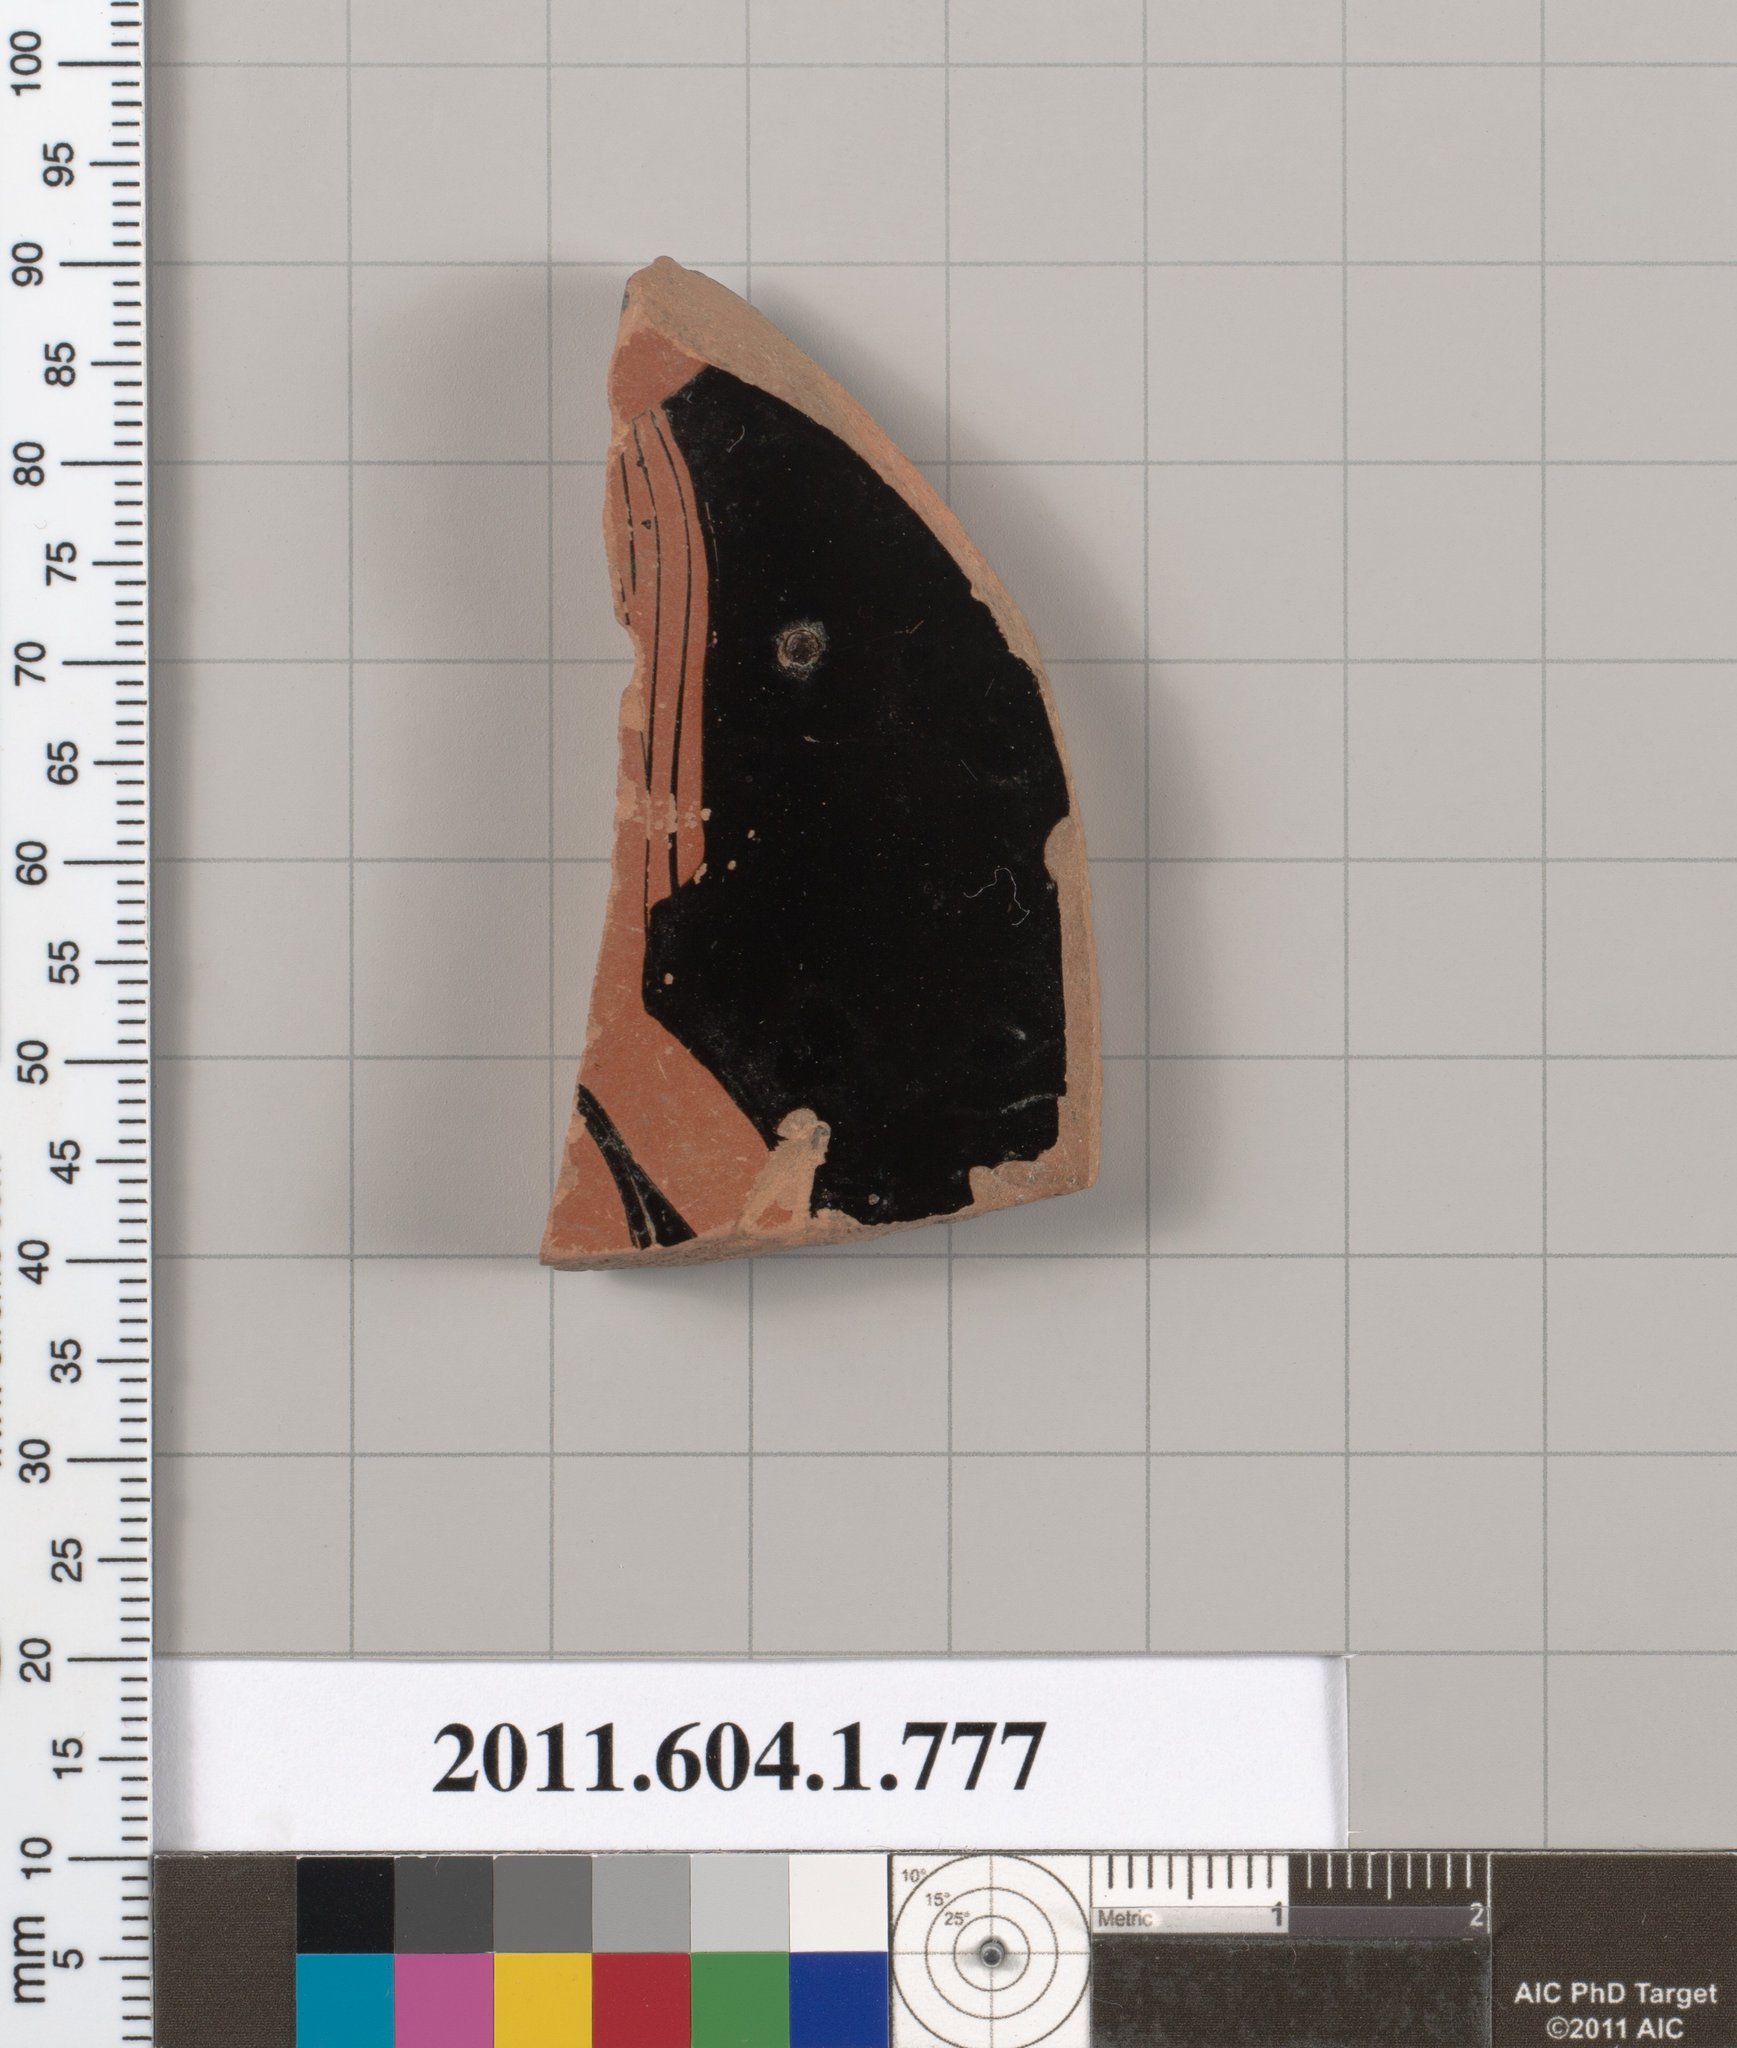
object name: kylix fragment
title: Terracotta fragment of a kylix (drinking cup)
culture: greek, attic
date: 475-451 BCE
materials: terracotta